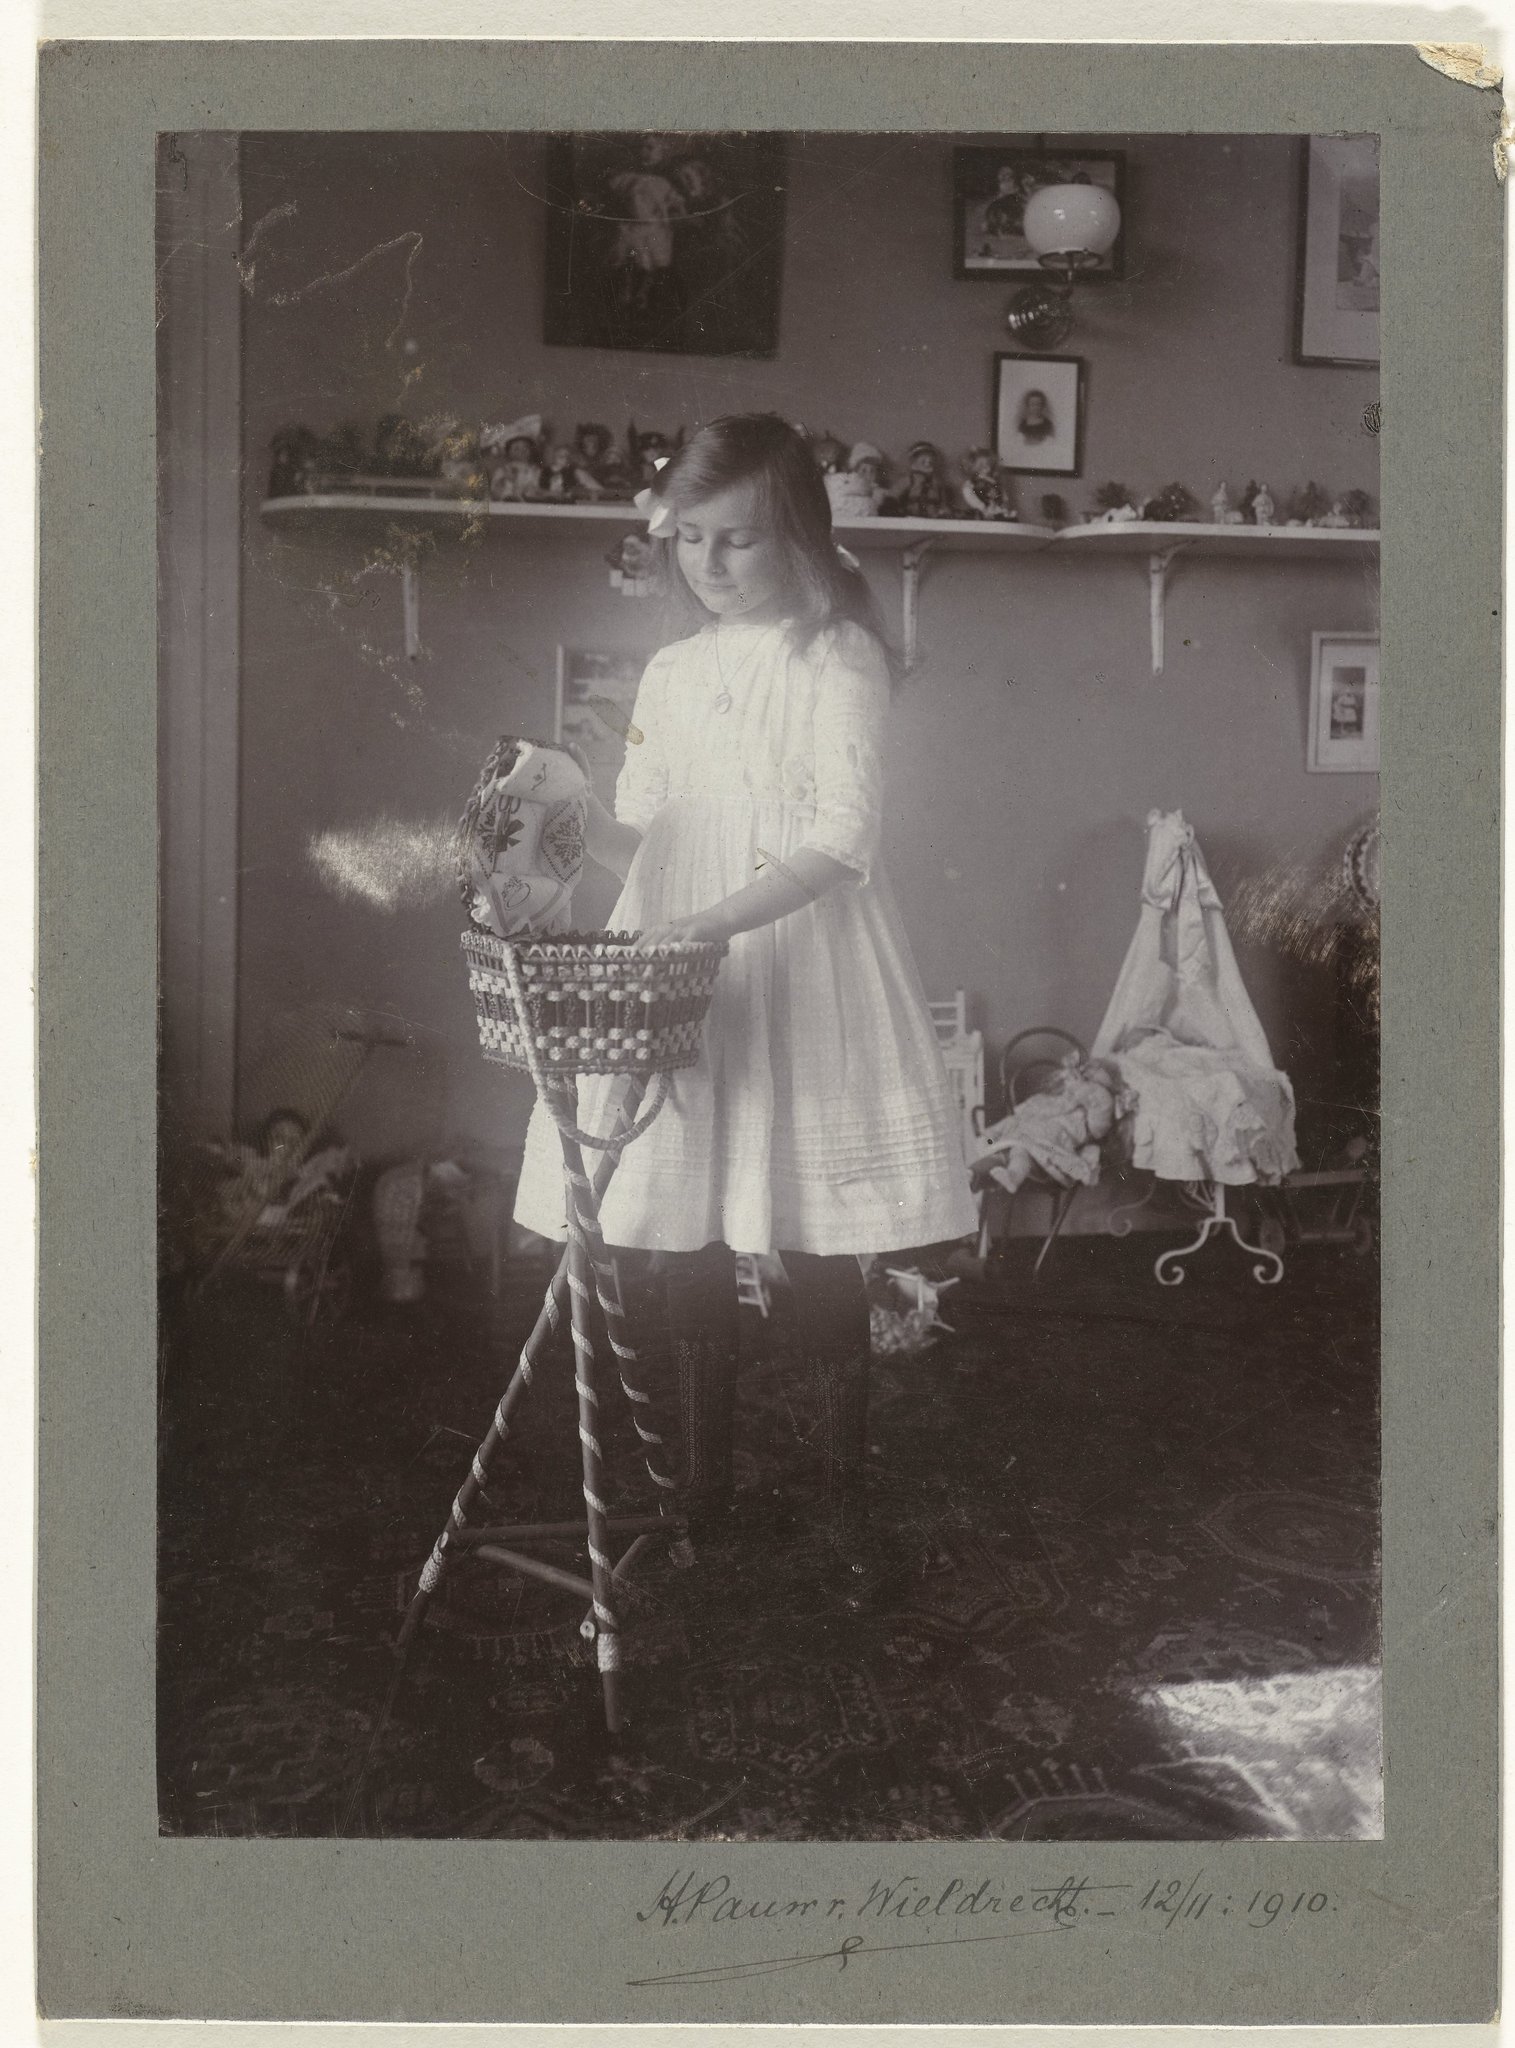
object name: photograph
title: Portret van Sacha, de oudste dochter van de fotograaf, in een kamer met speelgoed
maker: henry pauw van wieldrecht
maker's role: fotograaf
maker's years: 1863-1912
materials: cardboard, photographic support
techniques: collodion silver print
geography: netherlands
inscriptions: signature and date: ‘H. Pauw v. Wieldrecht. - 12/11:1910.’, annotation: ‘No 3757. / 1910.’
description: Sacha = Johanna Alexandra Pauw van Wieldrecht, geb. 12 november 1903.